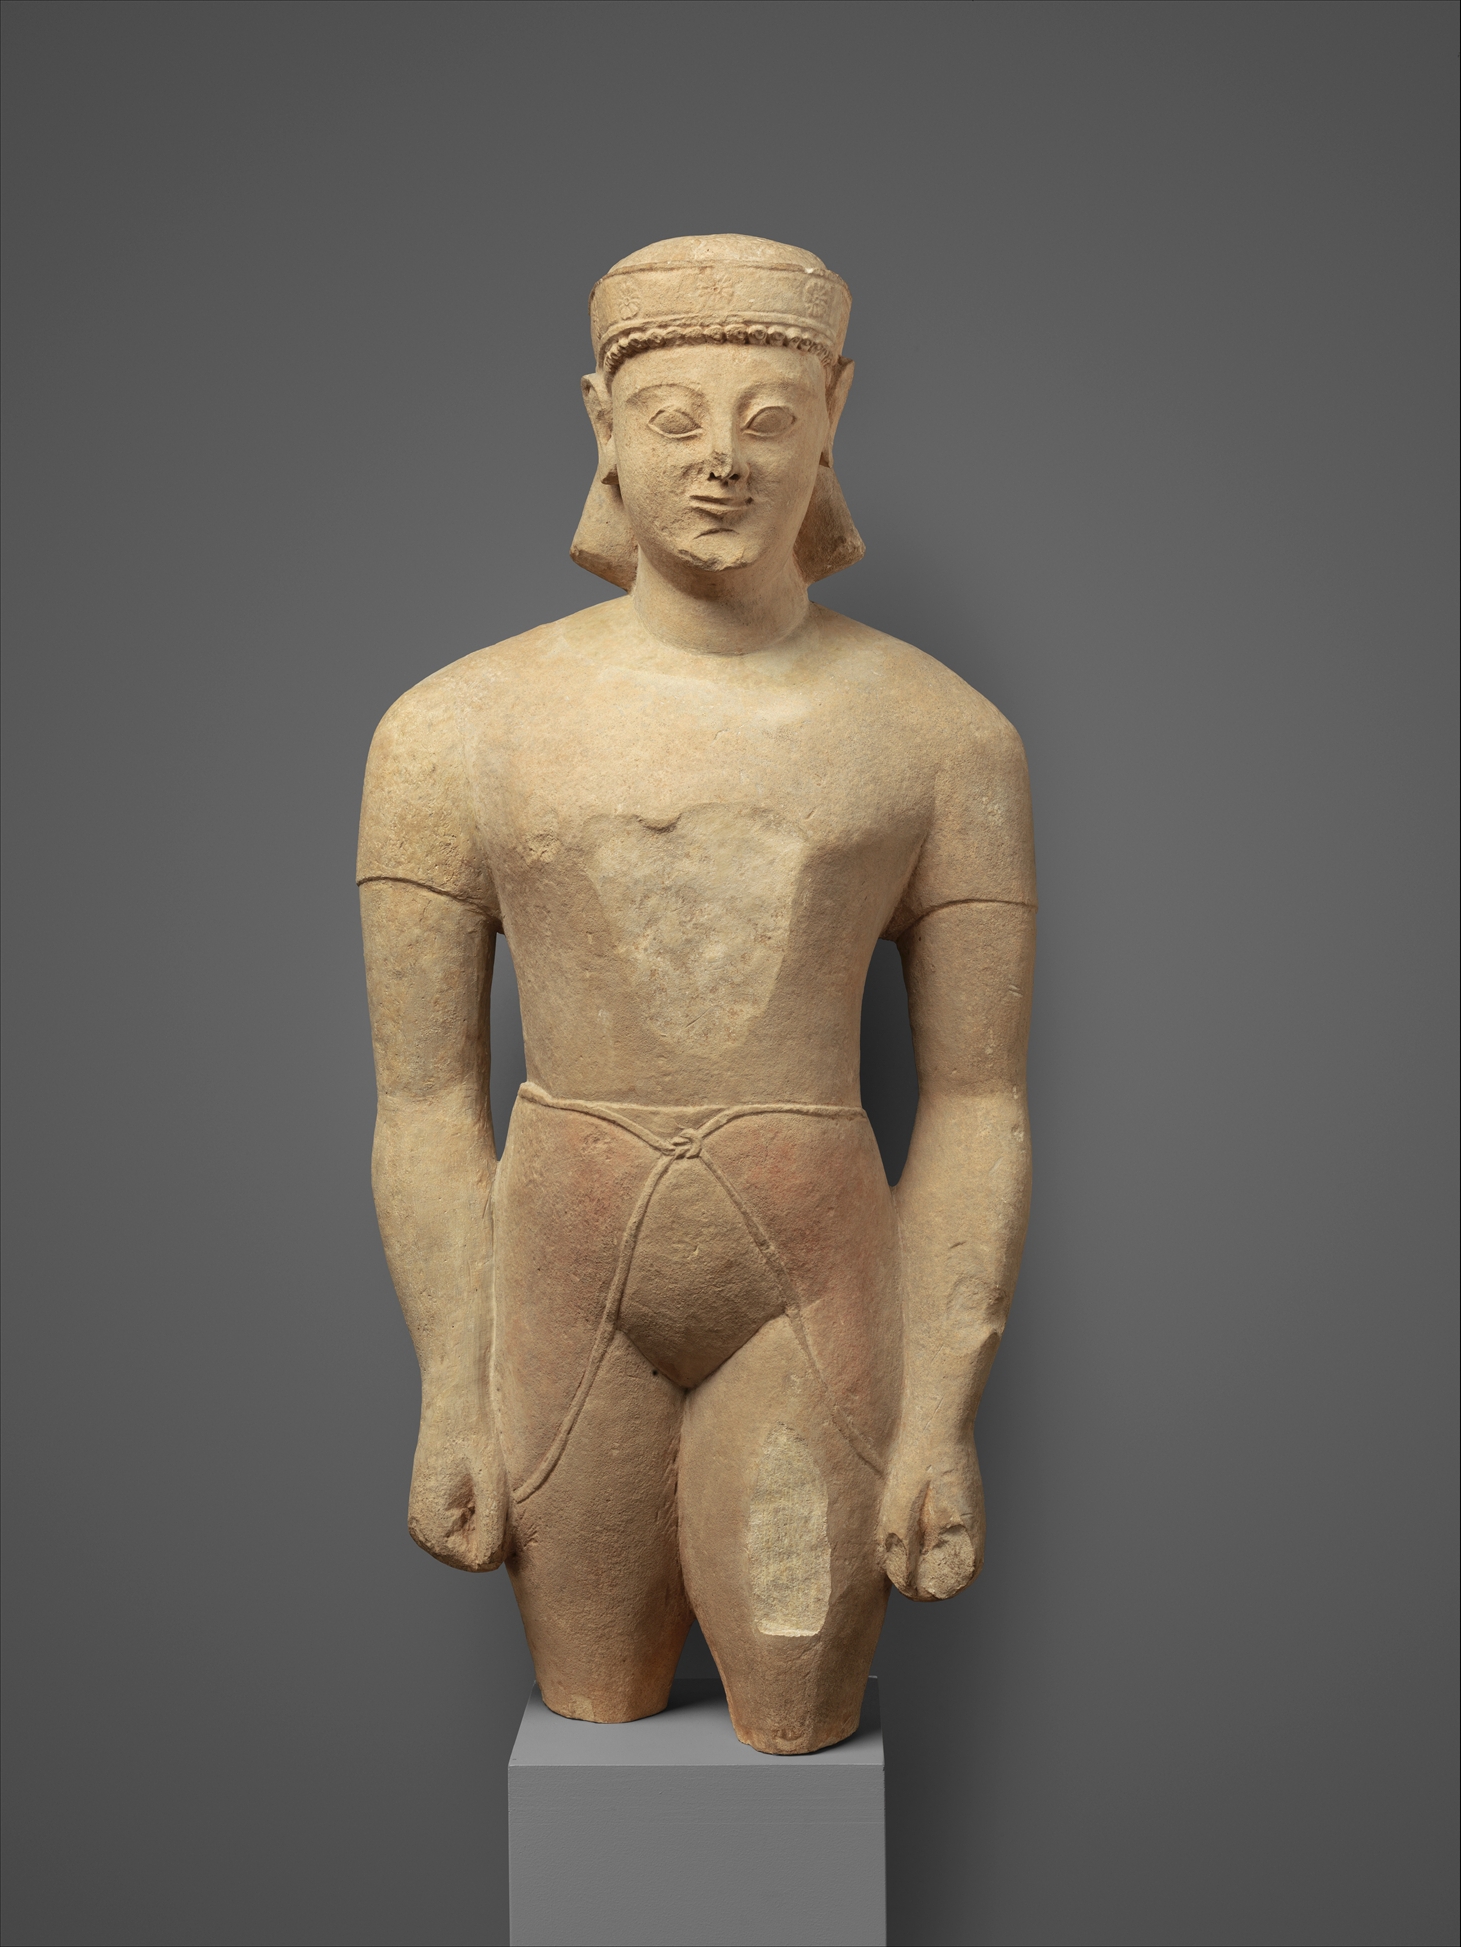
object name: statue of a votary, male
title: Limestone male figure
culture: cypriot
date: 567-535 BCE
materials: limestone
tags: men